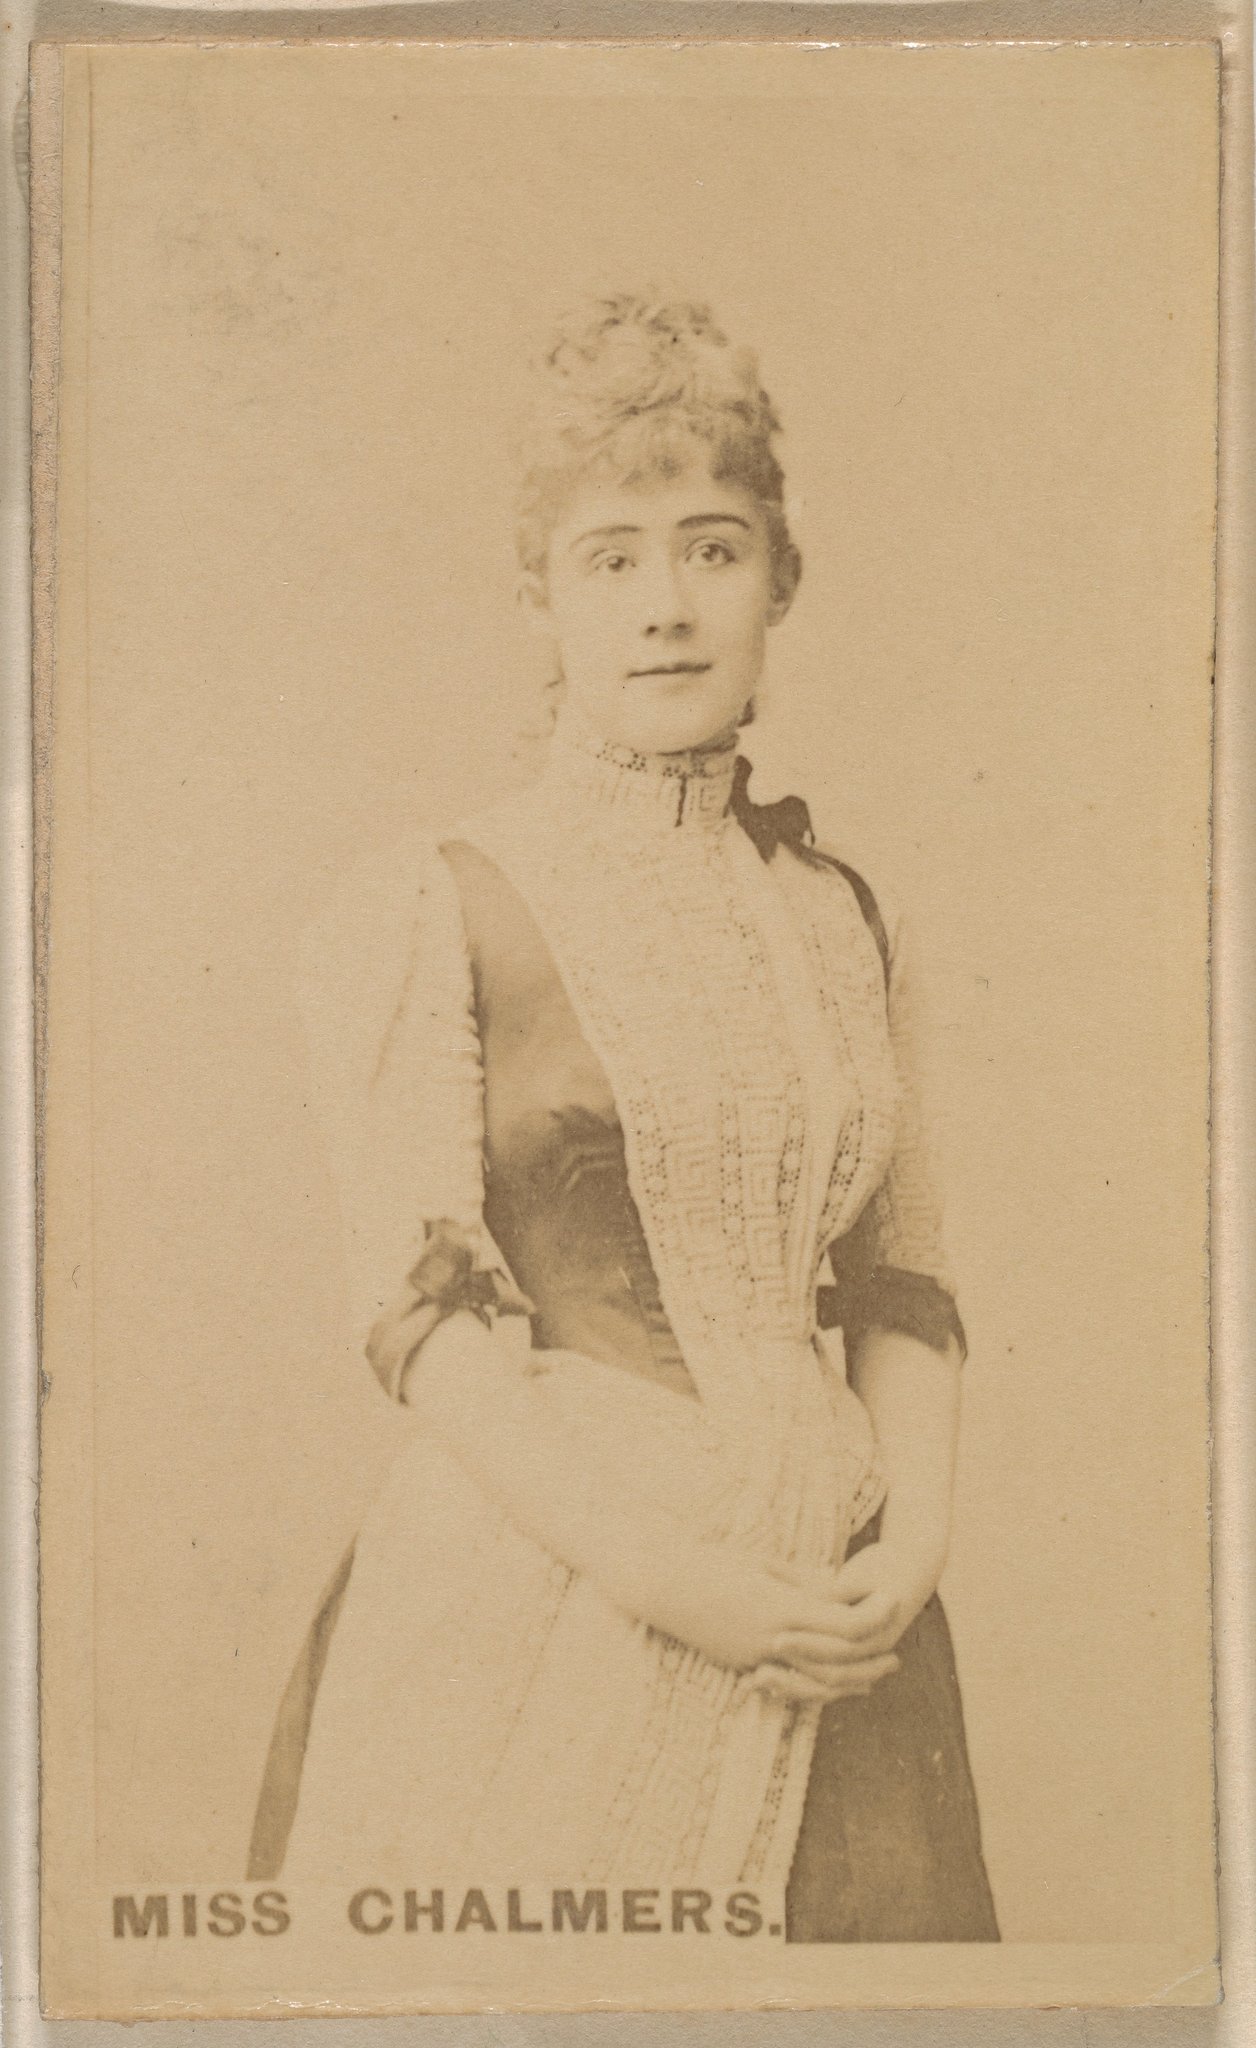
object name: photograph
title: Miss Chalmers, from the Actresses series (N246), Type 1, issued by Kinney Brothers to promote Sporting Extra Cigarettes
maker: kinney brothers tobacco company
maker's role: publisher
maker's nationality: american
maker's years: 1869-2011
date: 1890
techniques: albumen silver print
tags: portraits,women,actresses